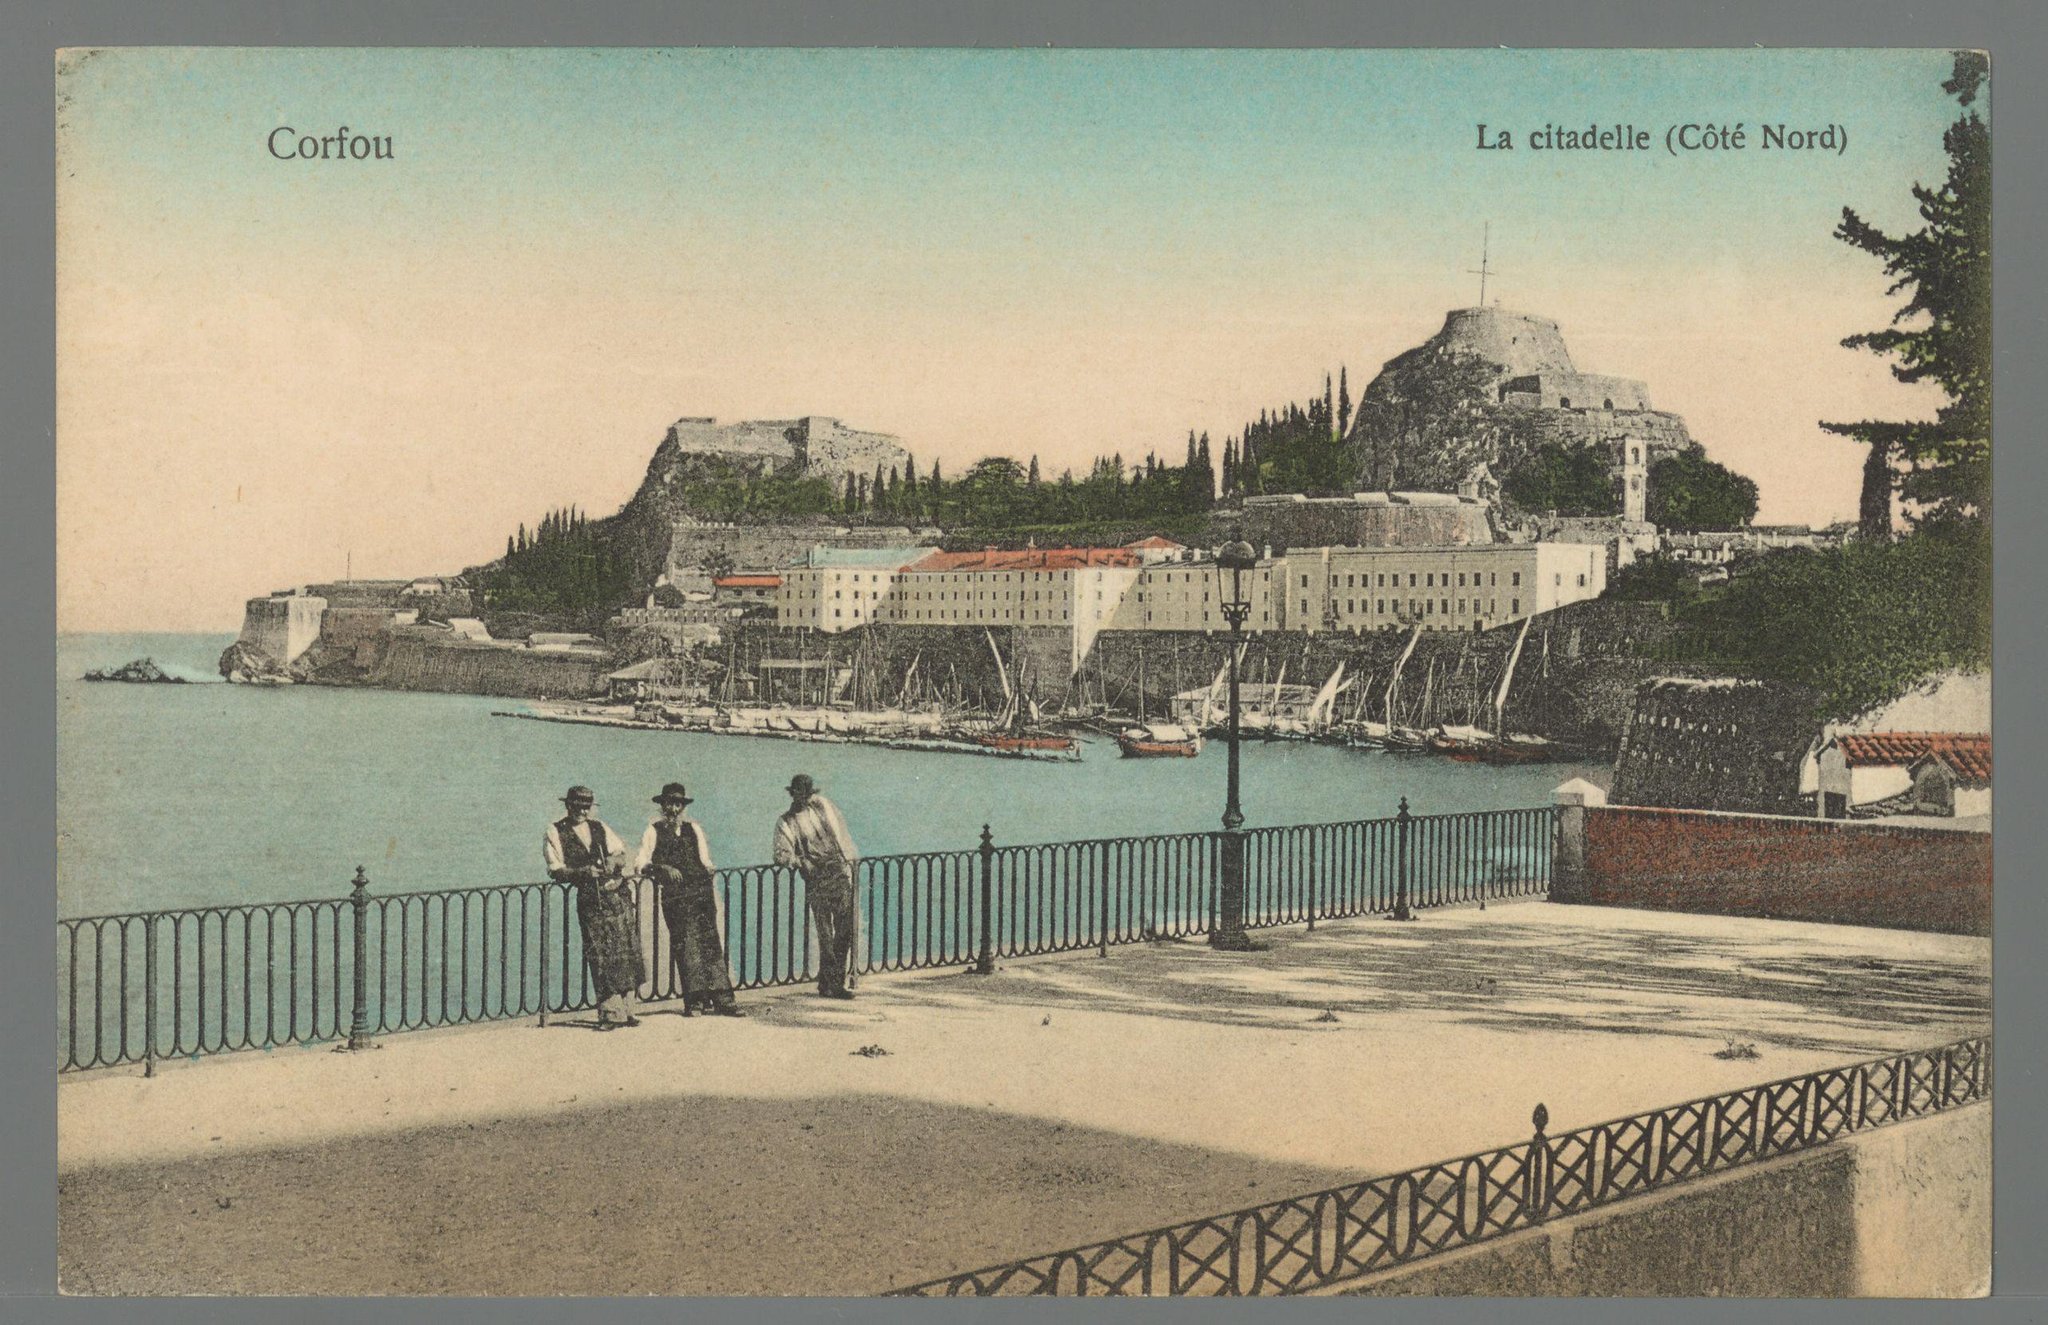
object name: ansichtkaart, prentbriefkaart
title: Corfou. La citadelle (Côté Nord)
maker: Anonymous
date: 1906-1909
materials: cardboard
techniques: photograph, lithograph, writing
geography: corfu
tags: fortress, sea